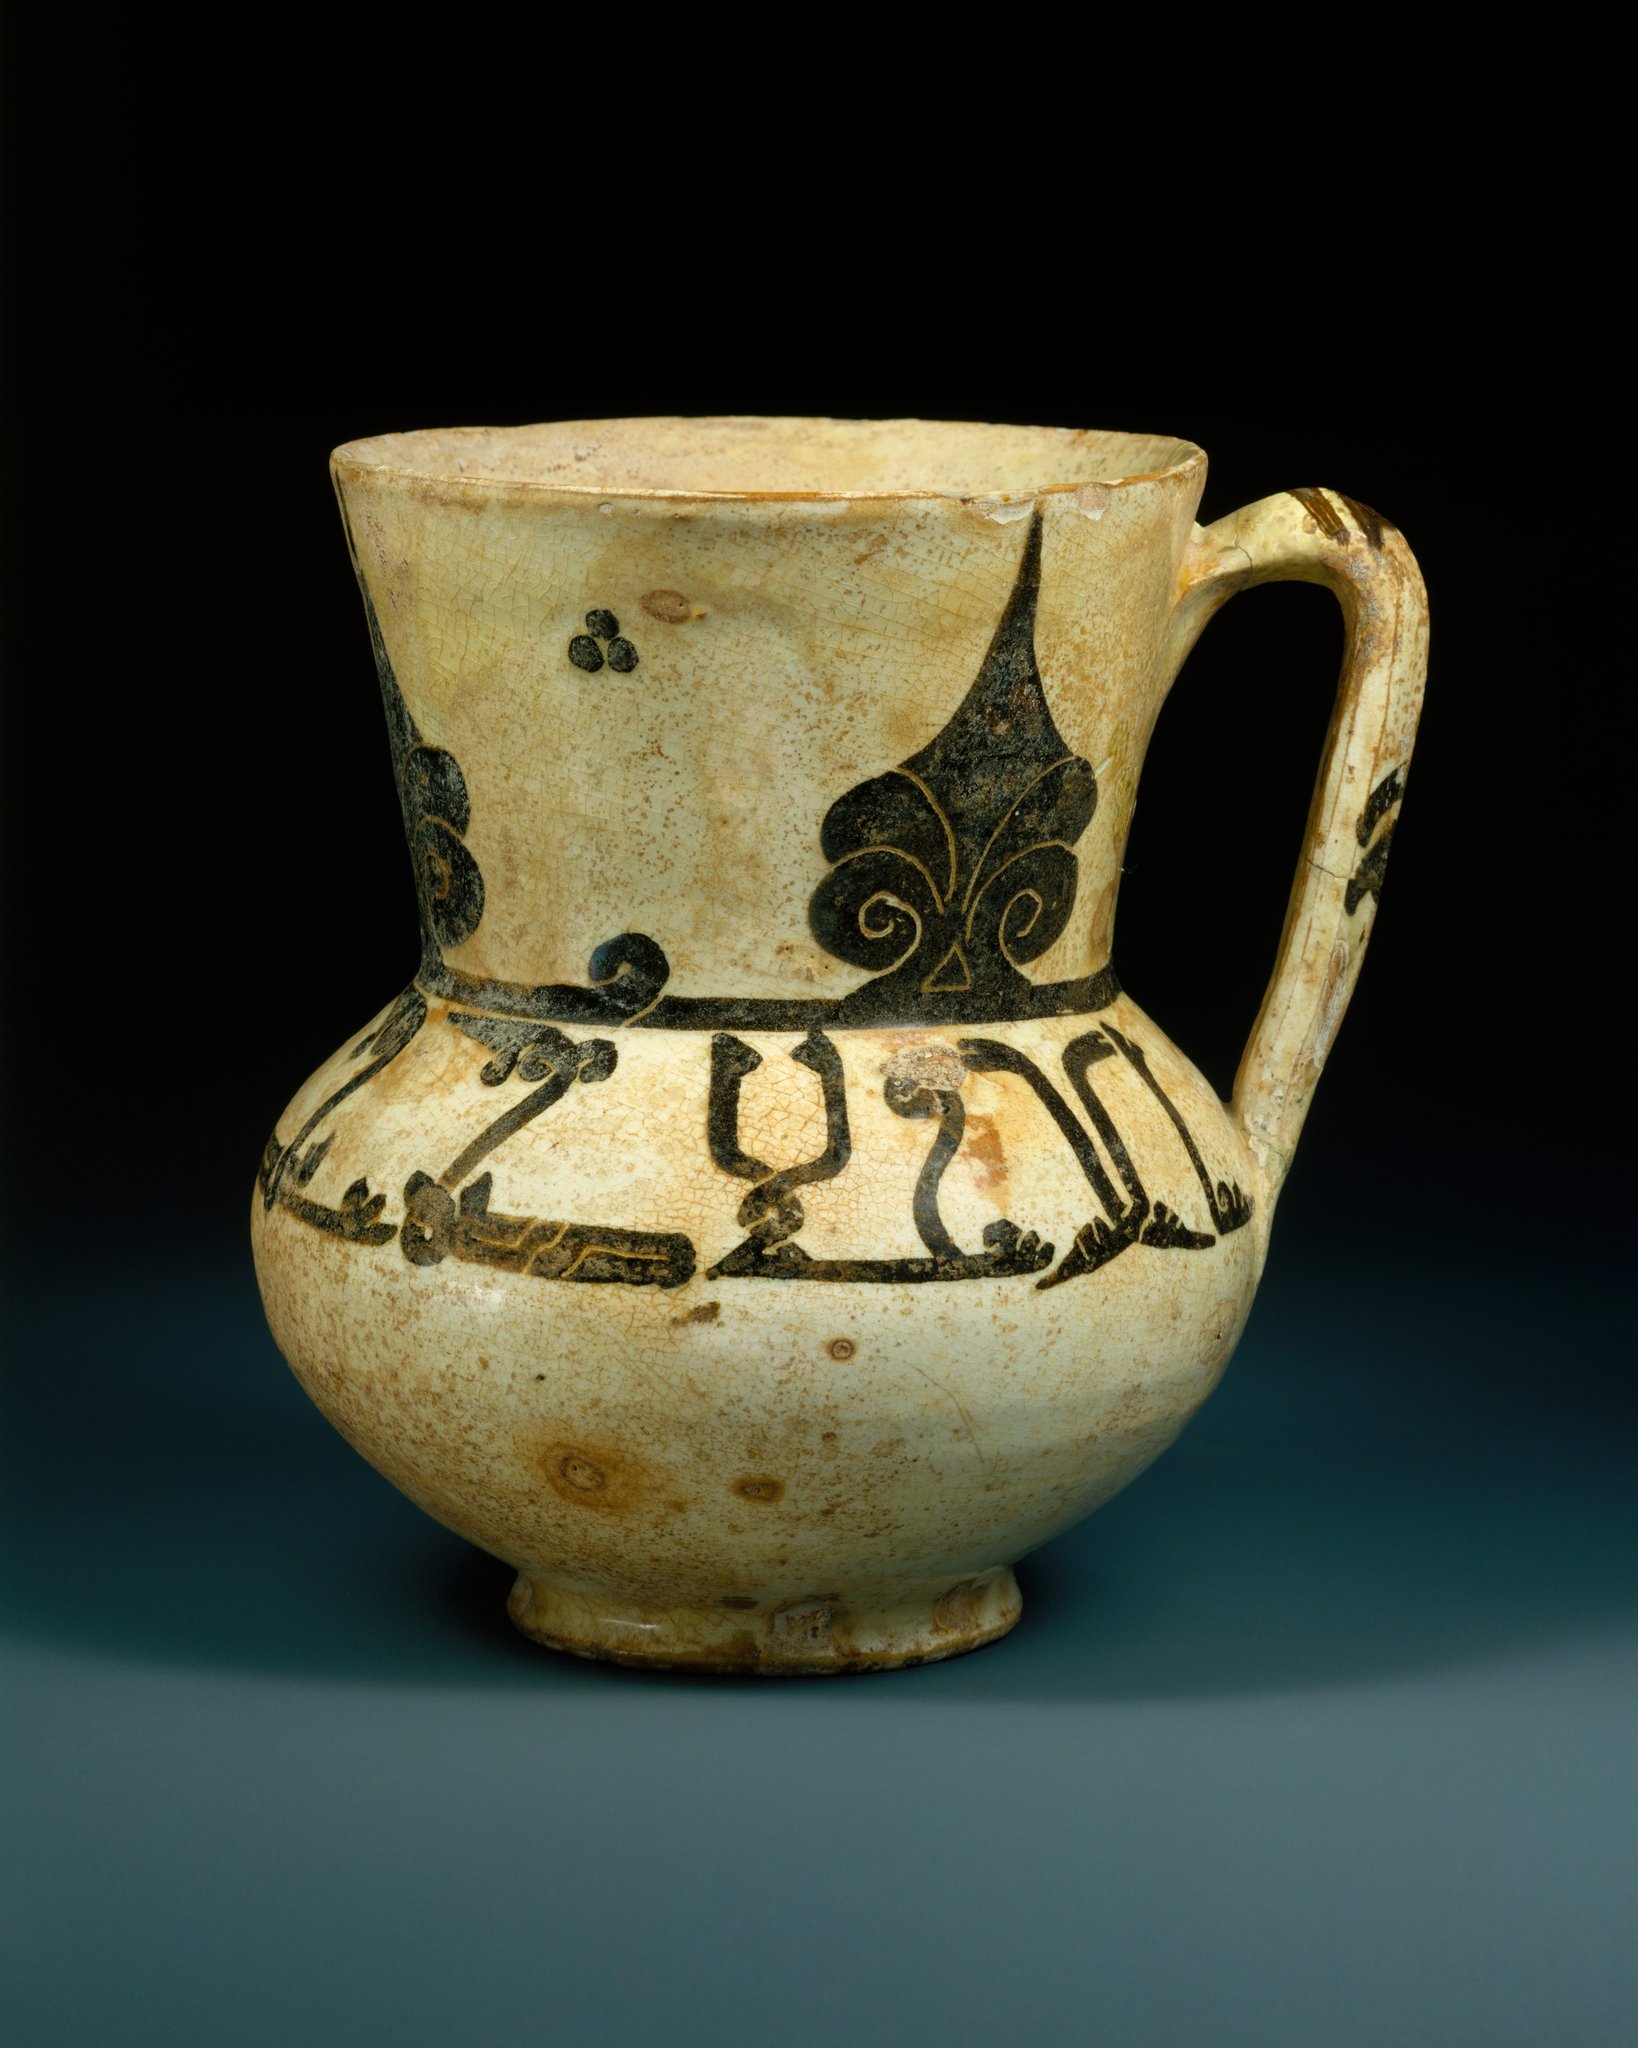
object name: ewer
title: Ewer with Arabic Proverb, "Devotion Fortifies Action"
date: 901-1000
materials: earthenware, glaze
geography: uzbekistan